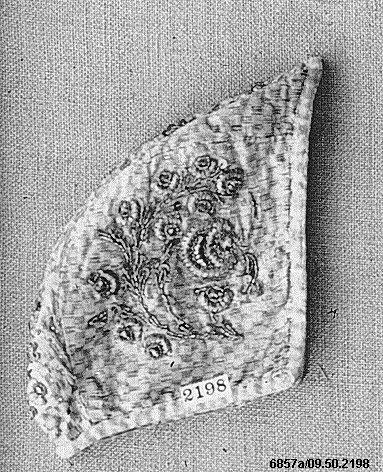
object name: cap crown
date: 1801-1833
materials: cotton, metal thread